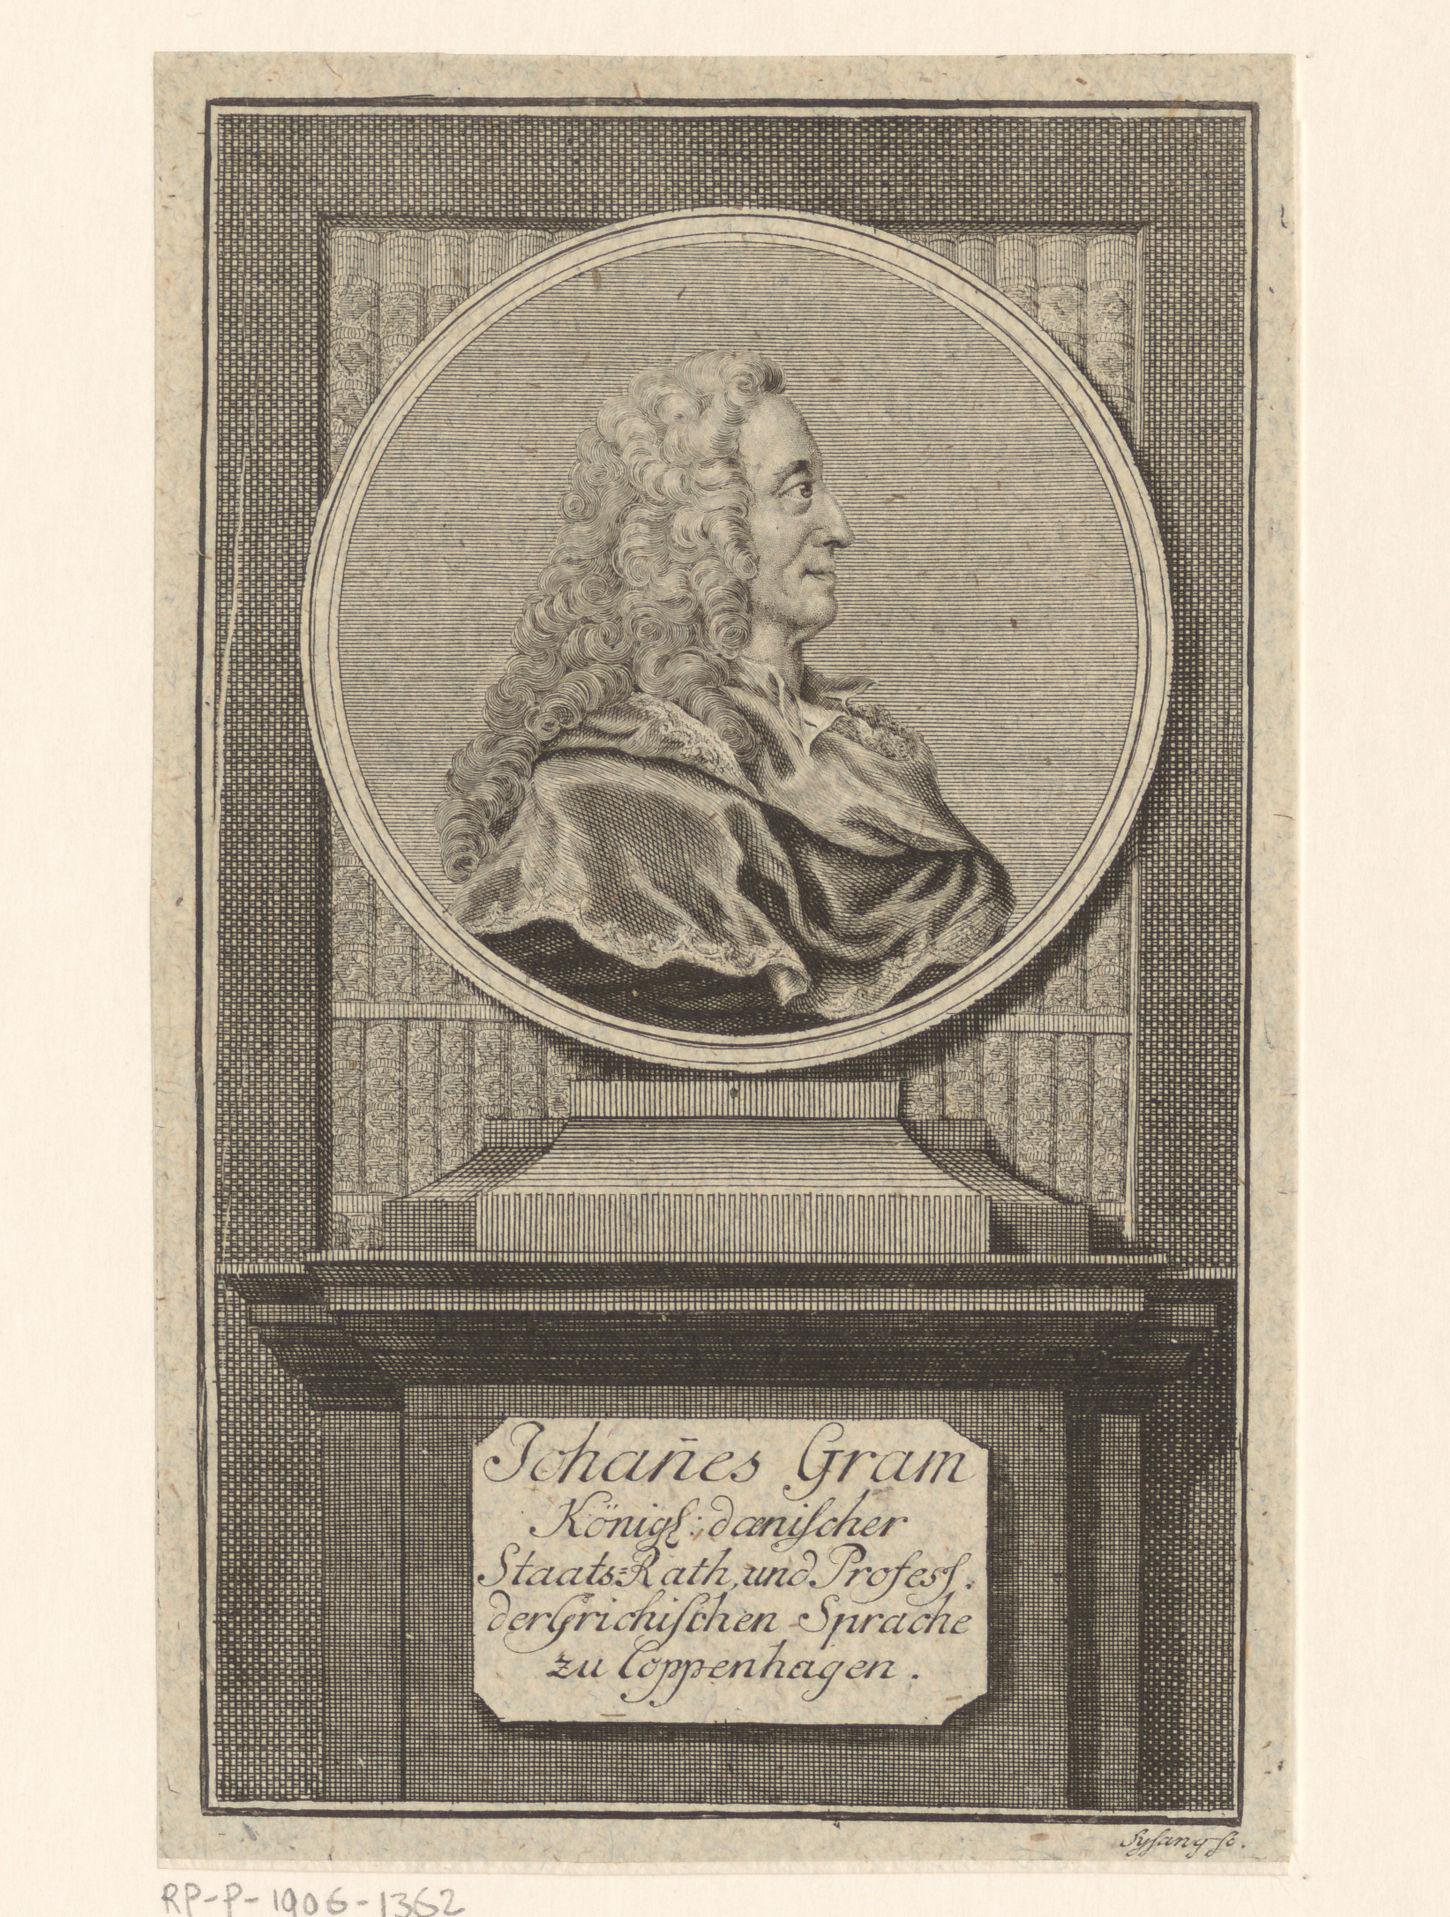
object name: print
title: Portret van Hans Gram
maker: johann christoph sysang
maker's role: print maker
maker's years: 1703-1757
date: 1749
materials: paper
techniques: engraving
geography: germany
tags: copenhagen (city), bookshelves, historical persons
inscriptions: collector's mark: Lugt 2228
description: Prent gebruikt voor de publicatie: Zuverläßige Nachrichten von dem gegenwärtigen Zustande, Veränderung und Wachsthum der Wissenschaften. Leipzig: Johann Friedrich Gleditsch, 1749, dl. 115.